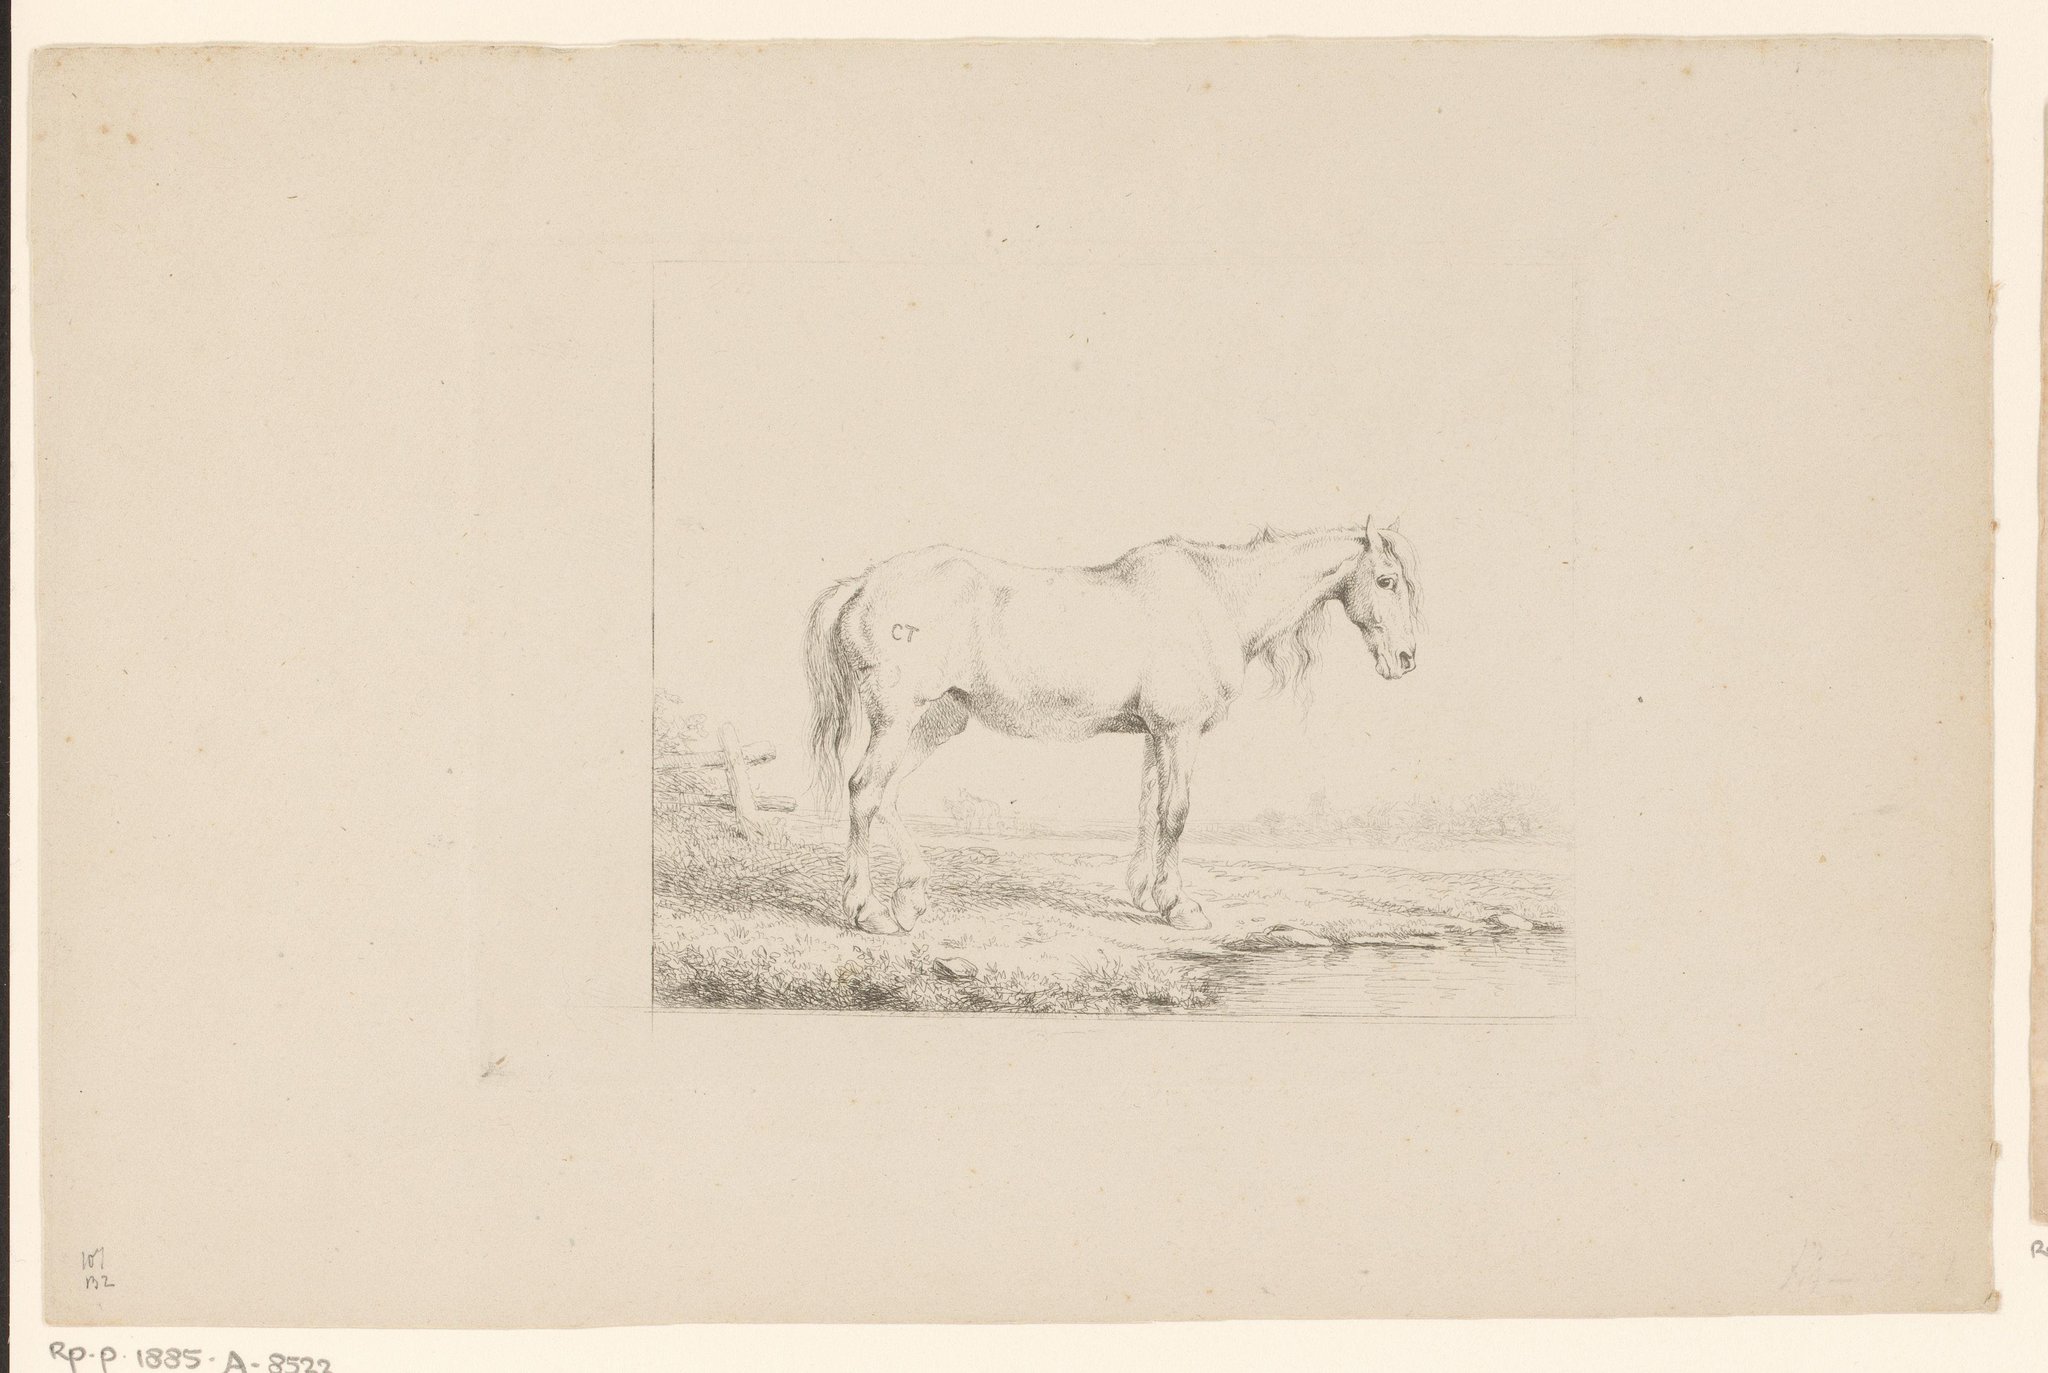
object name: print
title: Staand paard bij een rivier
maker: charles tschaggeny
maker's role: print maker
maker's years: 1815-1894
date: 1825-1885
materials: paper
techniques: etching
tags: horse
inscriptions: collector's mark: Lugt 2228